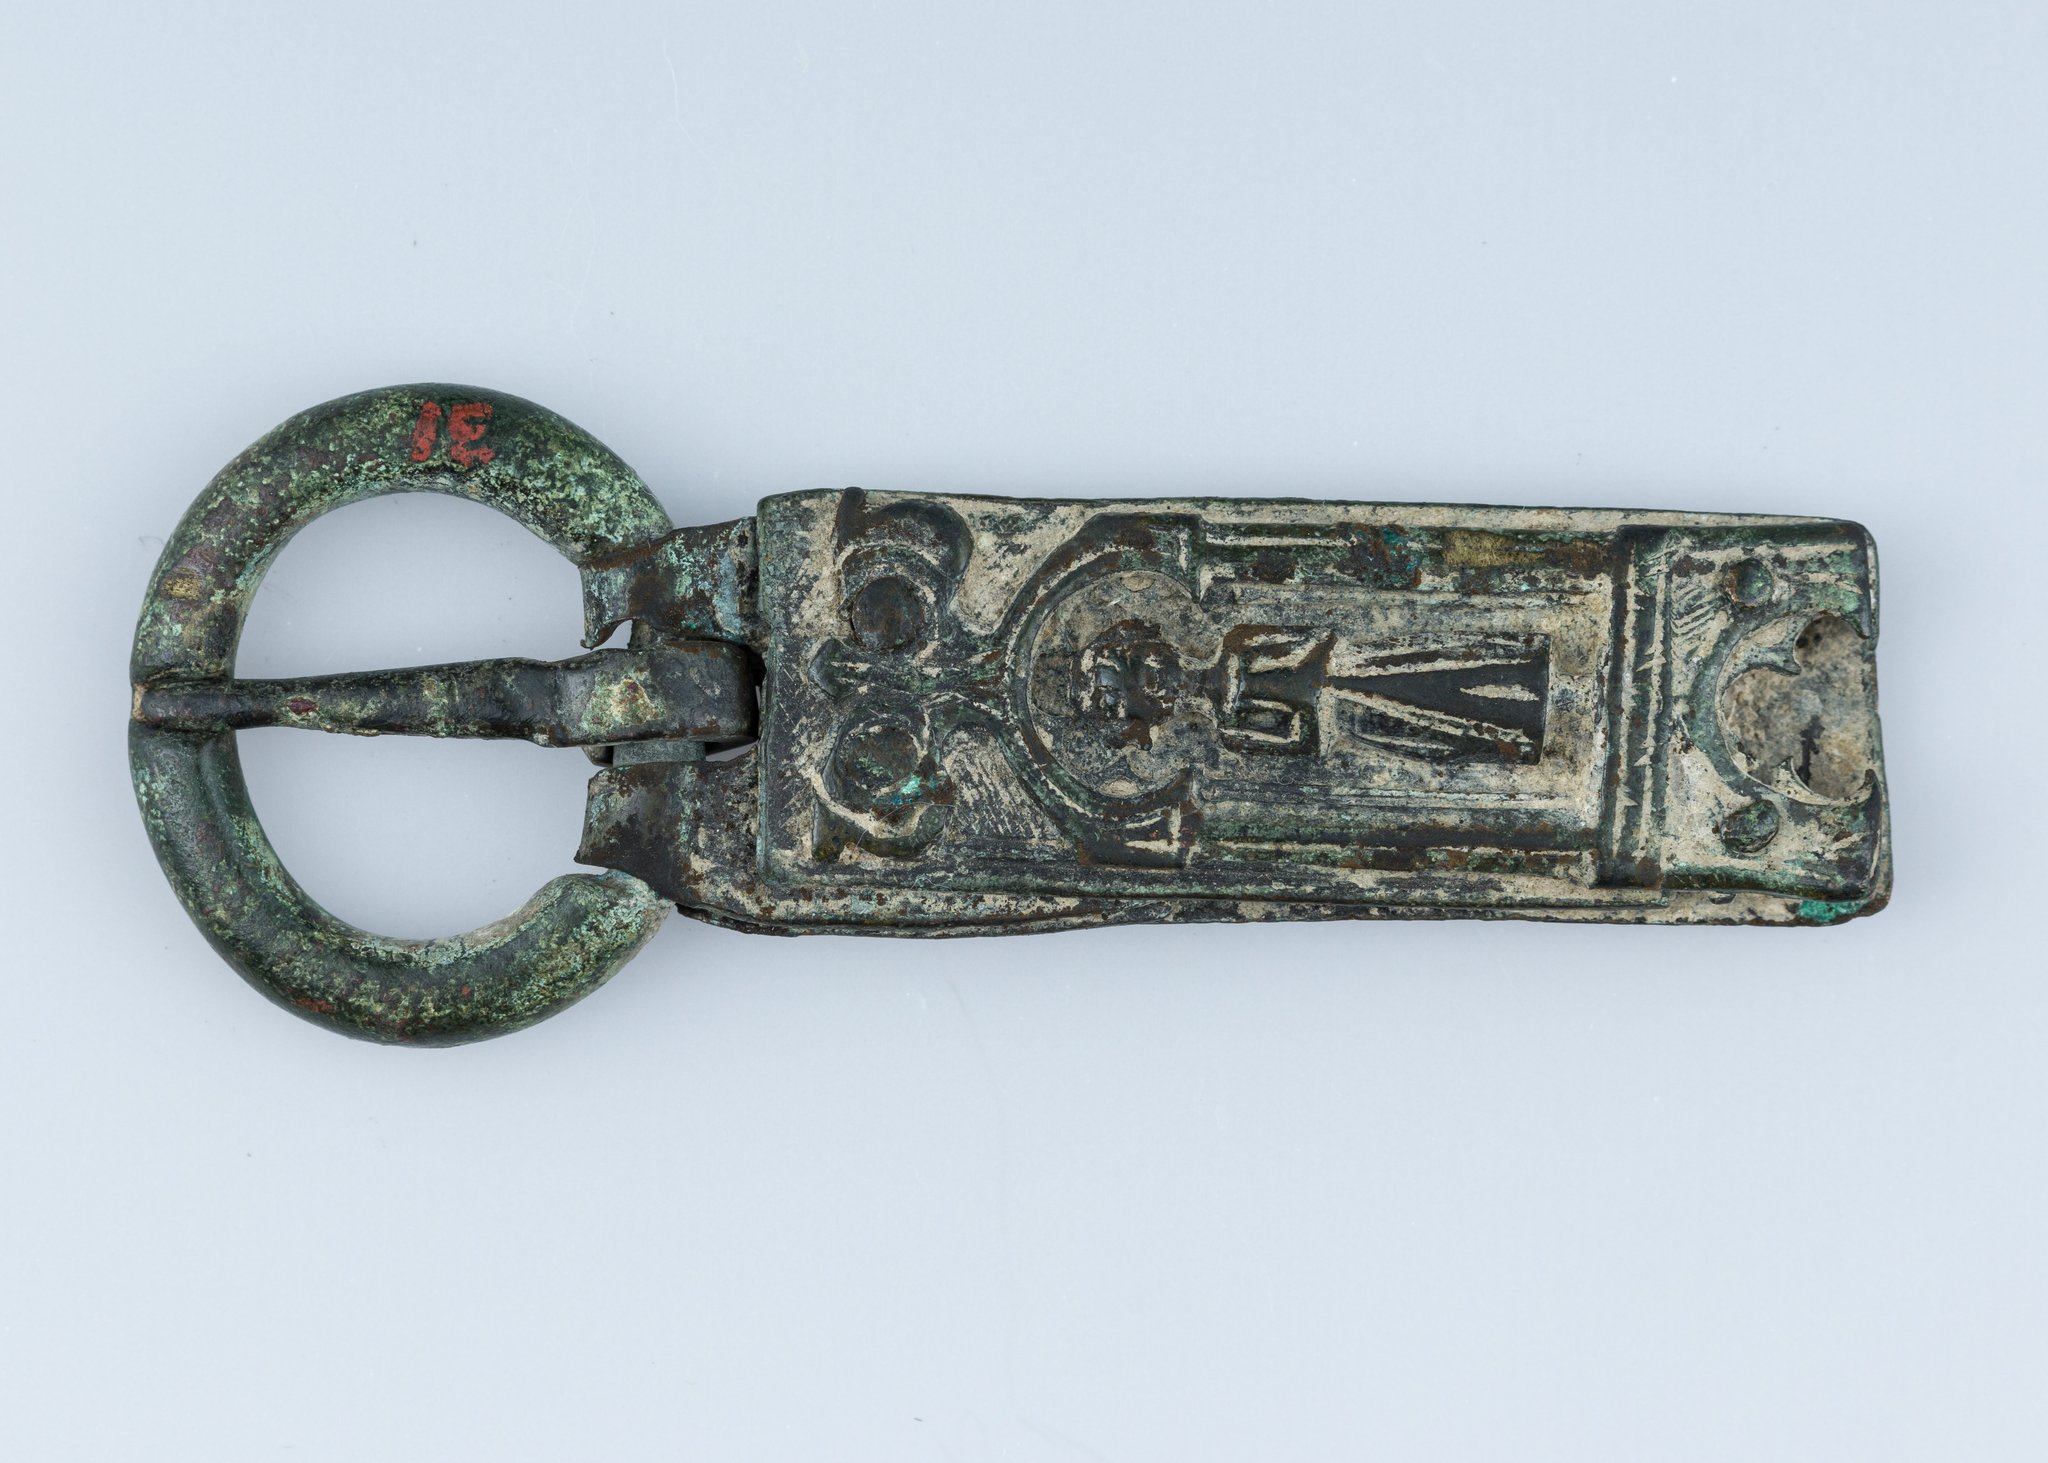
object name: buckle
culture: french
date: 1301-1400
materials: bronze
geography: france